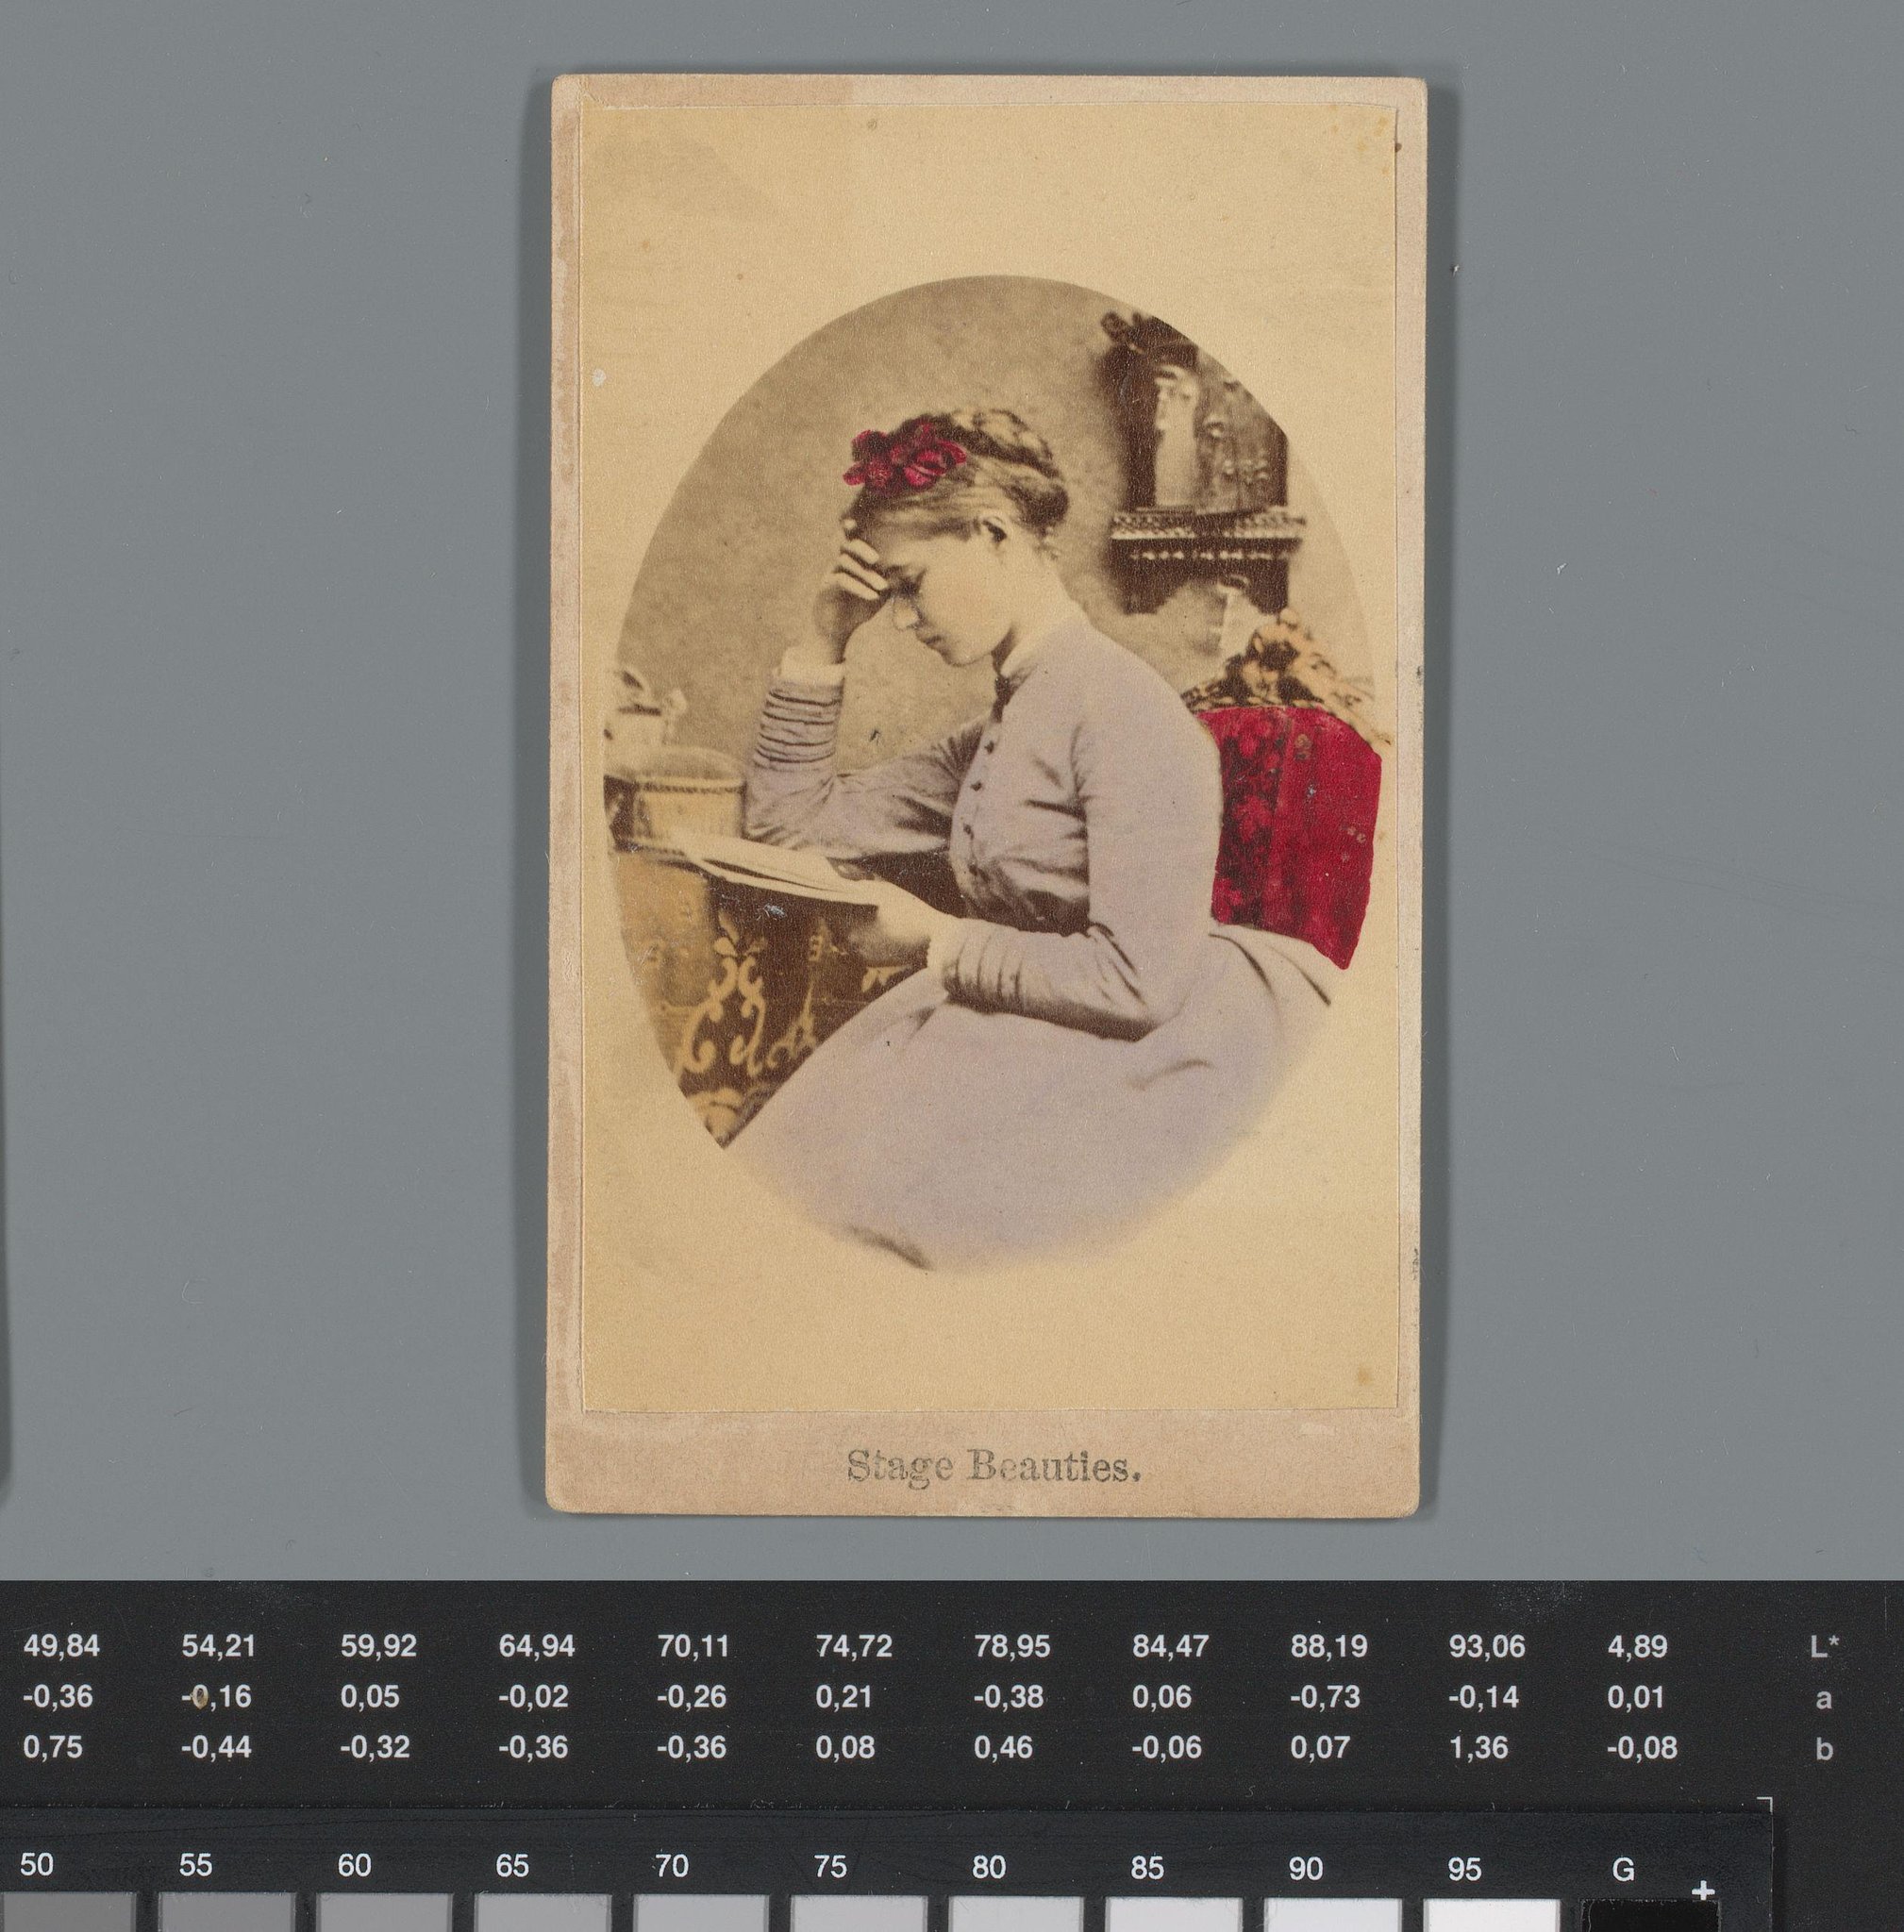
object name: photograph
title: Reclame voor huishoudelijke apparatuur van O'mara's met portret van een onbekende lezende vrouw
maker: Anonymous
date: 1850-1915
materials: cardboard, paint, photographic support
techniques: albumen print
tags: reading, advertising, historical persons not known by name - bb - woman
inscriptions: inscription: ‘O'MARA'S, (...) Stoves, Ranges, Hardware, (...) HOUSE FURNISHING GOODS’